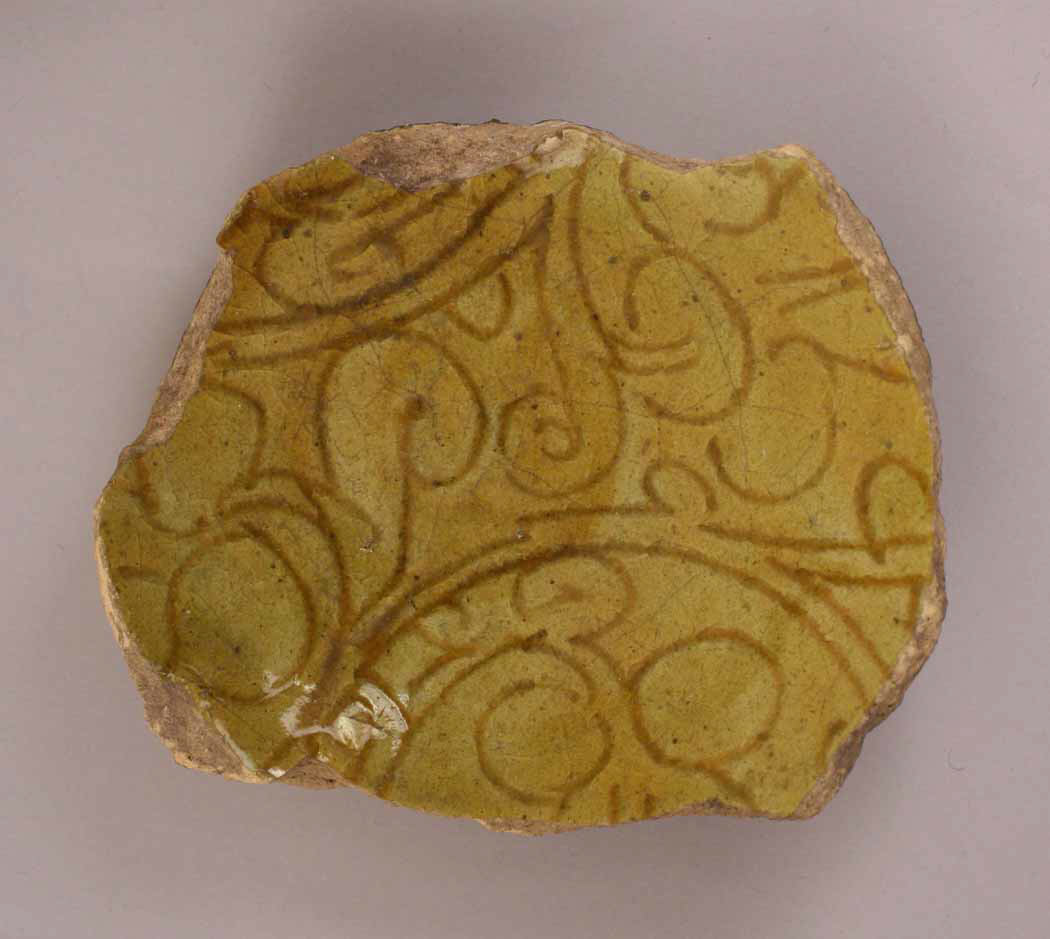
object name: ceramic fragment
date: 1201-1400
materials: earthenware, glaze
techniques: incising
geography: egypt